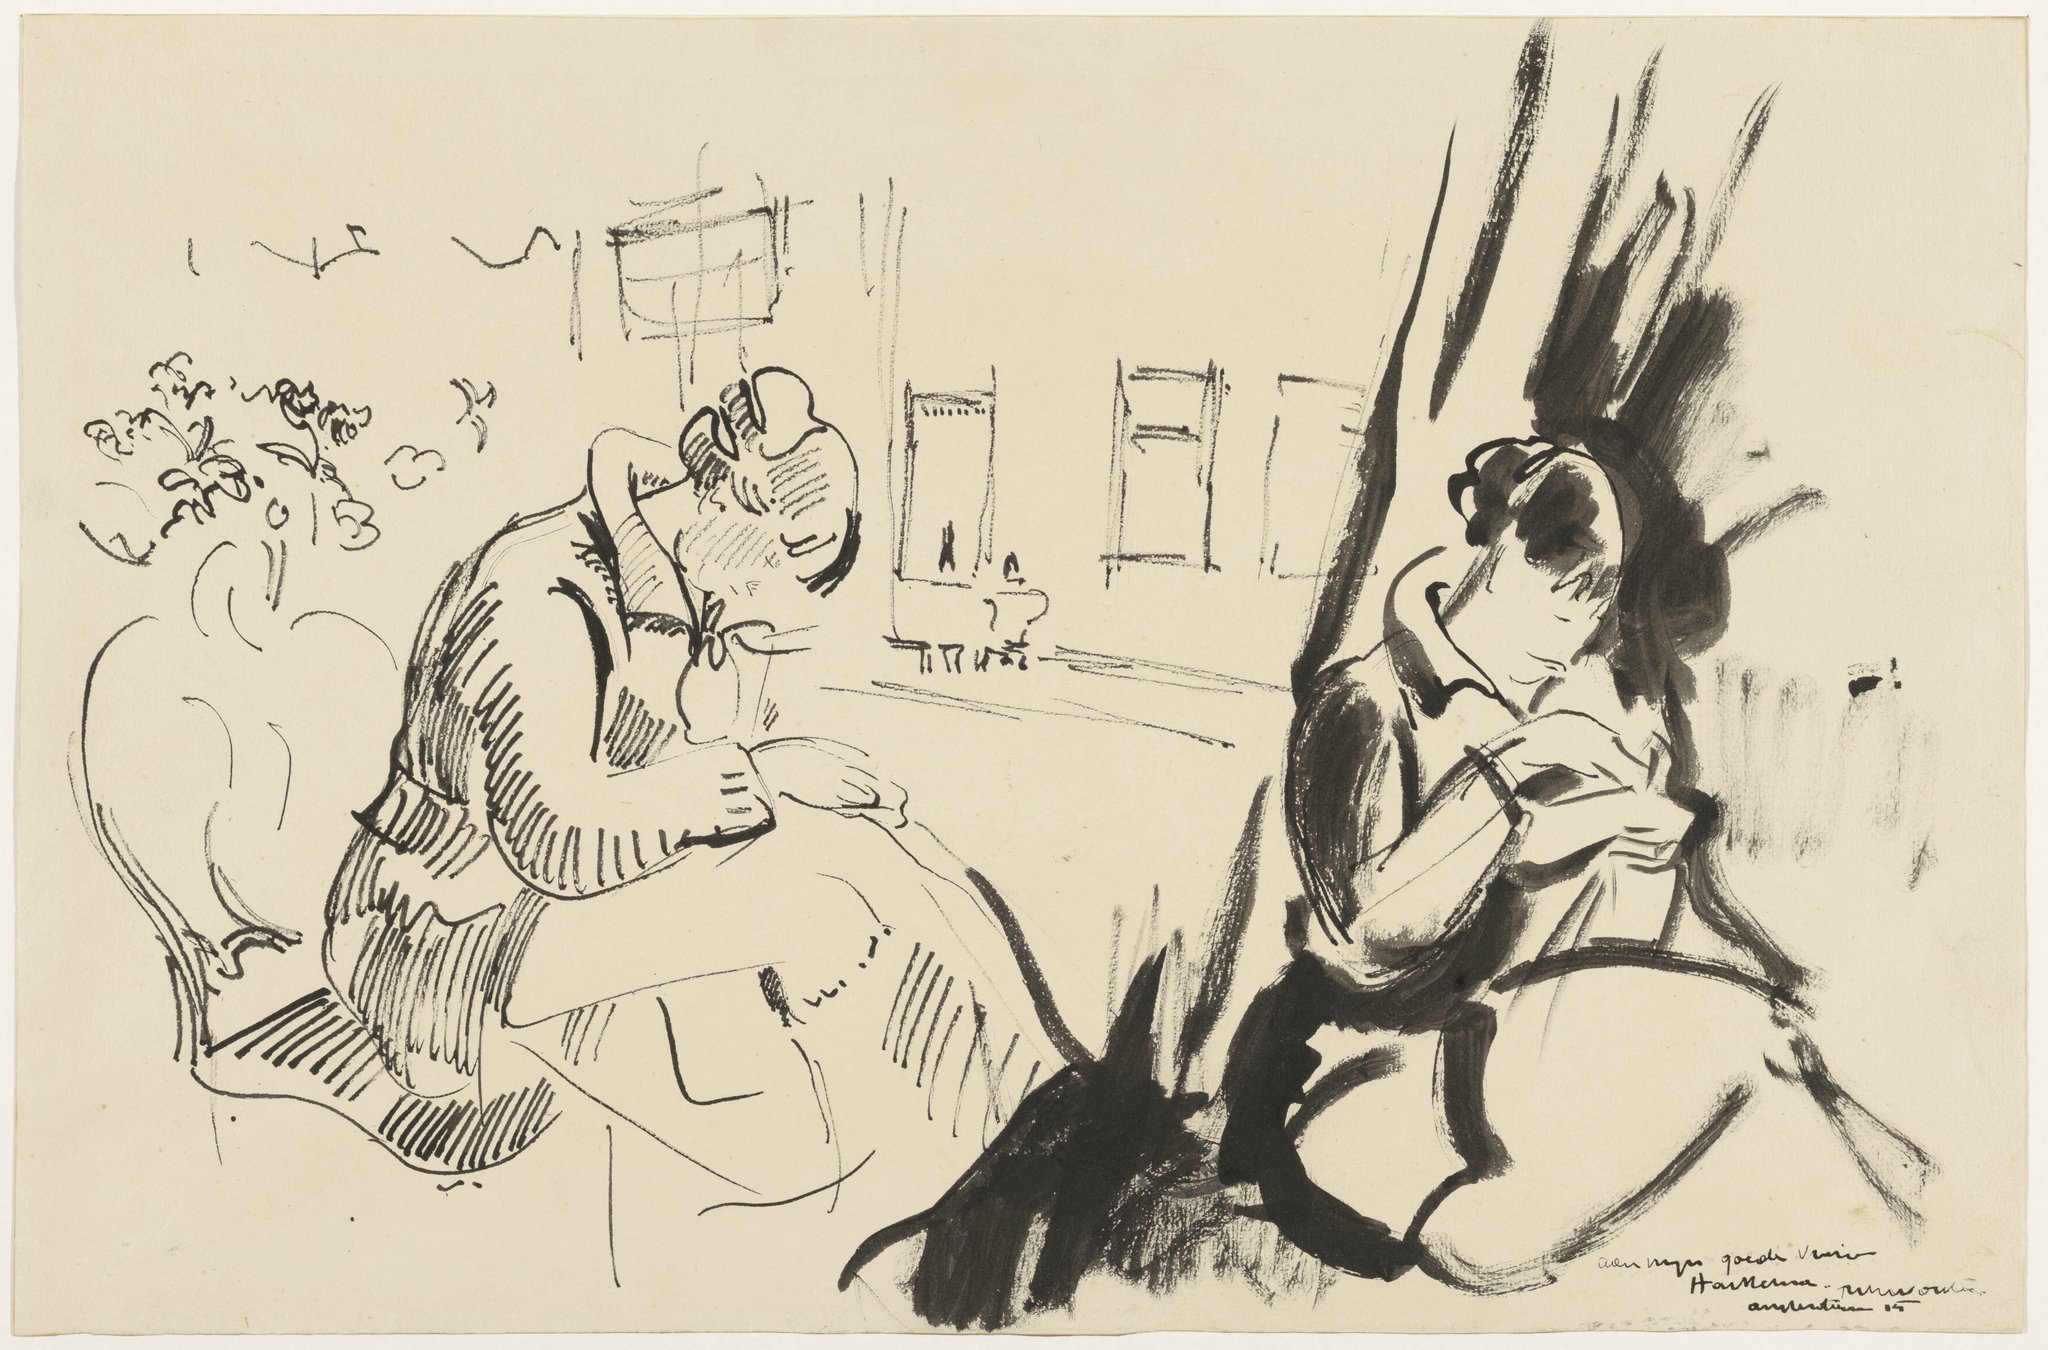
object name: drawing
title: Studies van een zittende, naaiende vrouw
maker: rik wouters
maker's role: draughtsman, print maker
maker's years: 1882-1916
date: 1915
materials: ink, paper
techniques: brush, pen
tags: sewing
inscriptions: dedication: ‘aan mijn goede vriend Harkema’, signature and date: ‘Rik Wouters Amsterdam 15’